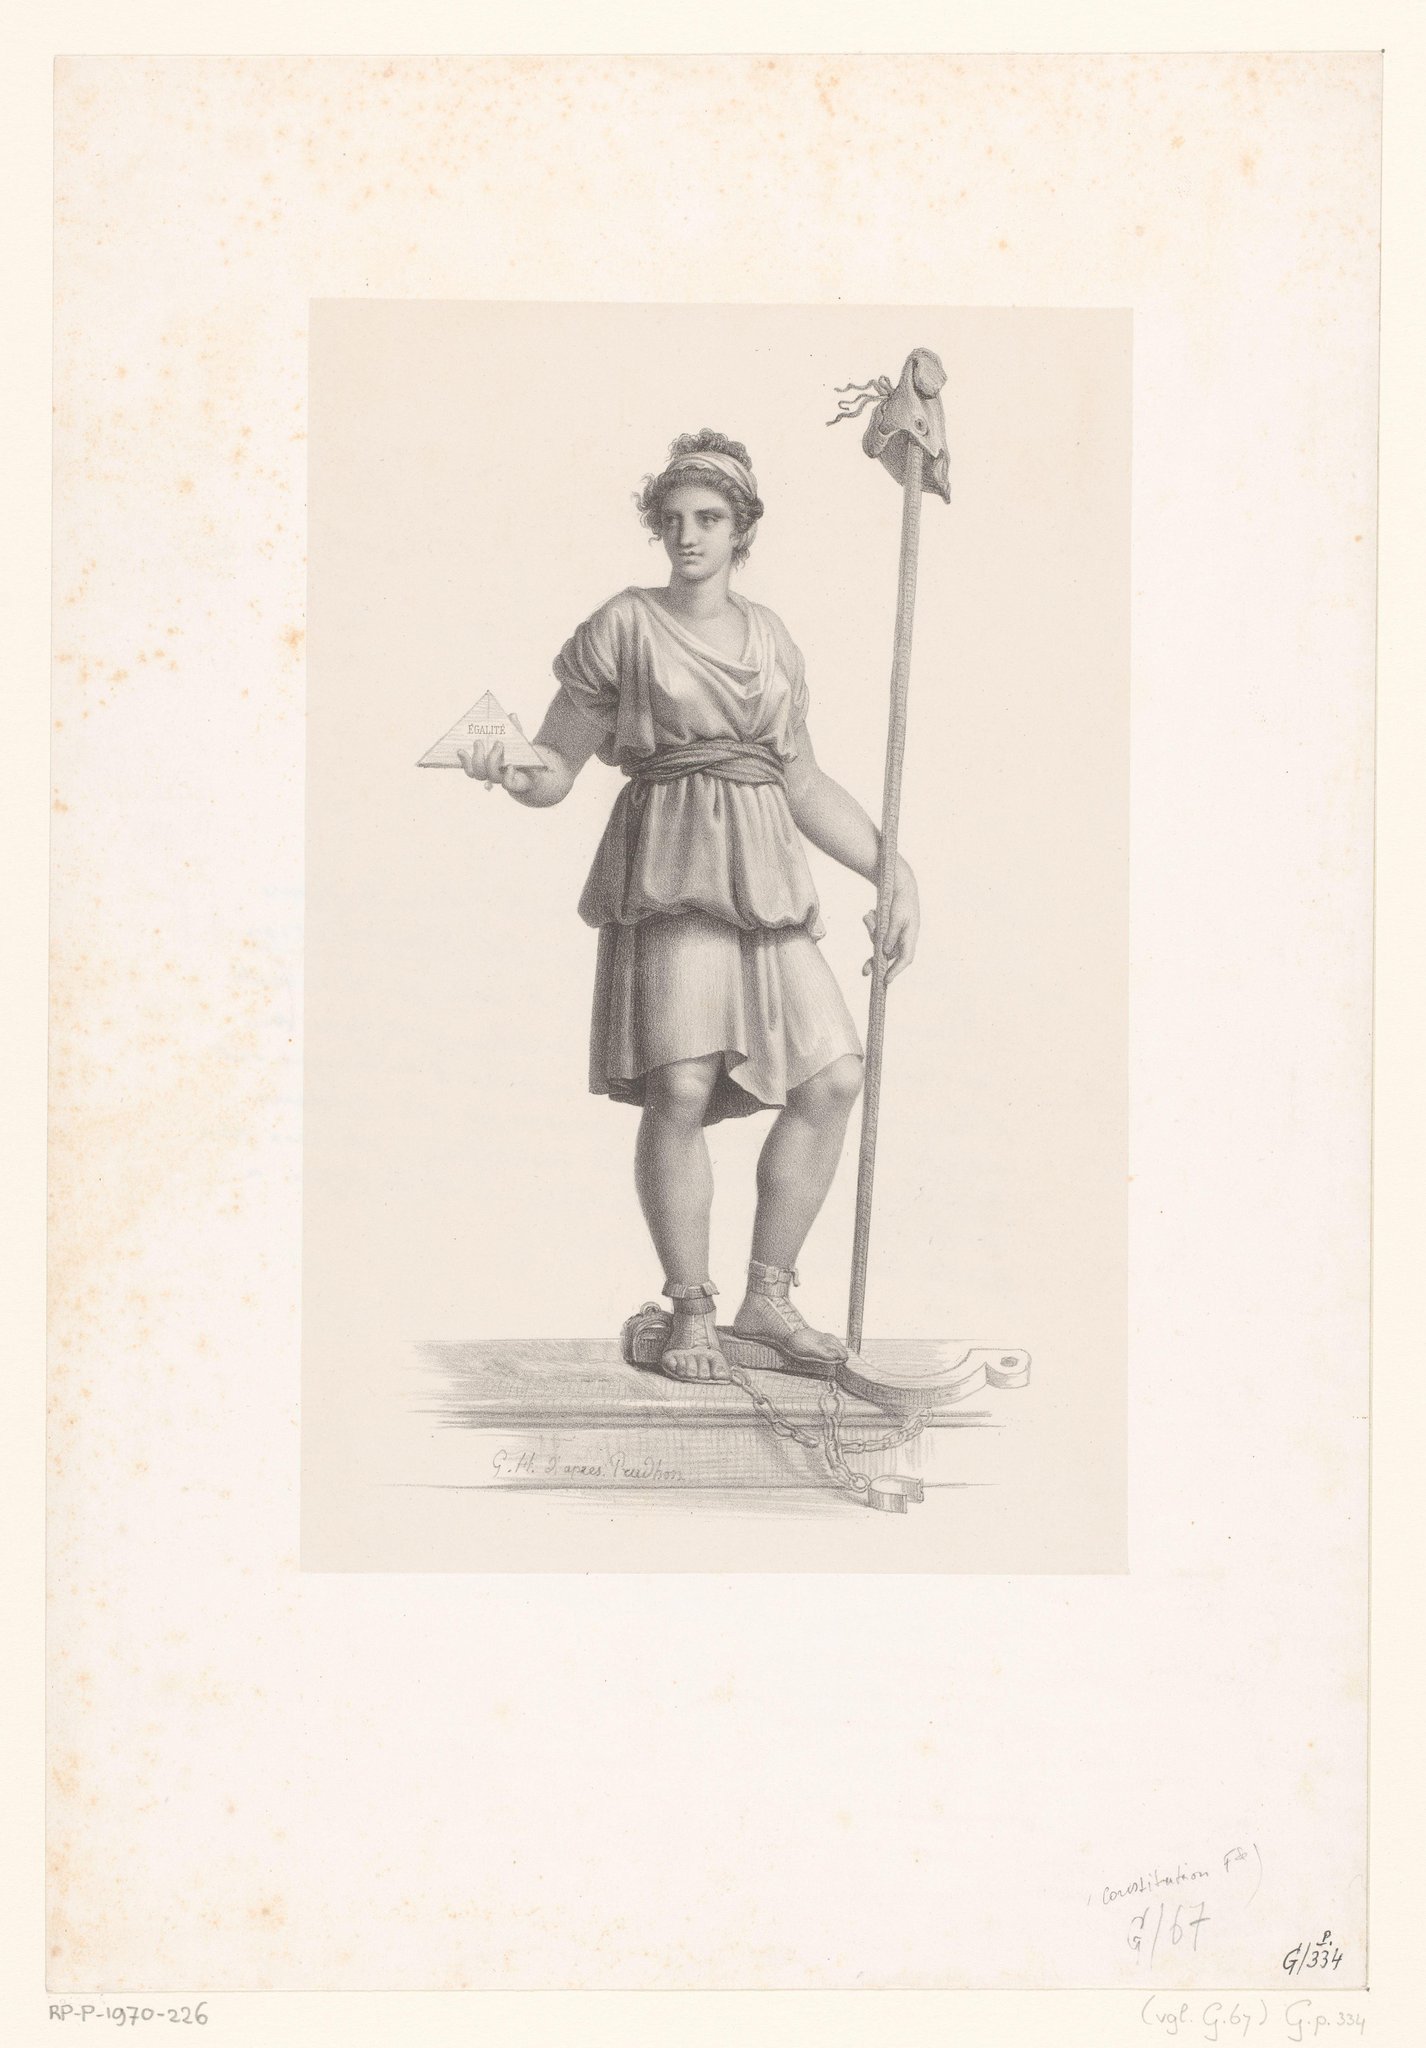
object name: print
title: Vrijheid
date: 1789-1799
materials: paper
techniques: lithograph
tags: libertas as roman personification, freedom, liberty; 'libertà' (ripa)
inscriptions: collector's mark: Lugt 2760, collector's mark: Lugt 2228